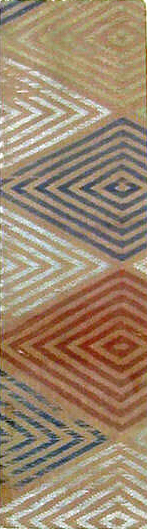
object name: piece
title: Textile with Concentric Lozenges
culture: japanese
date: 1615-1868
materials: silk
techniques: brocade, weave